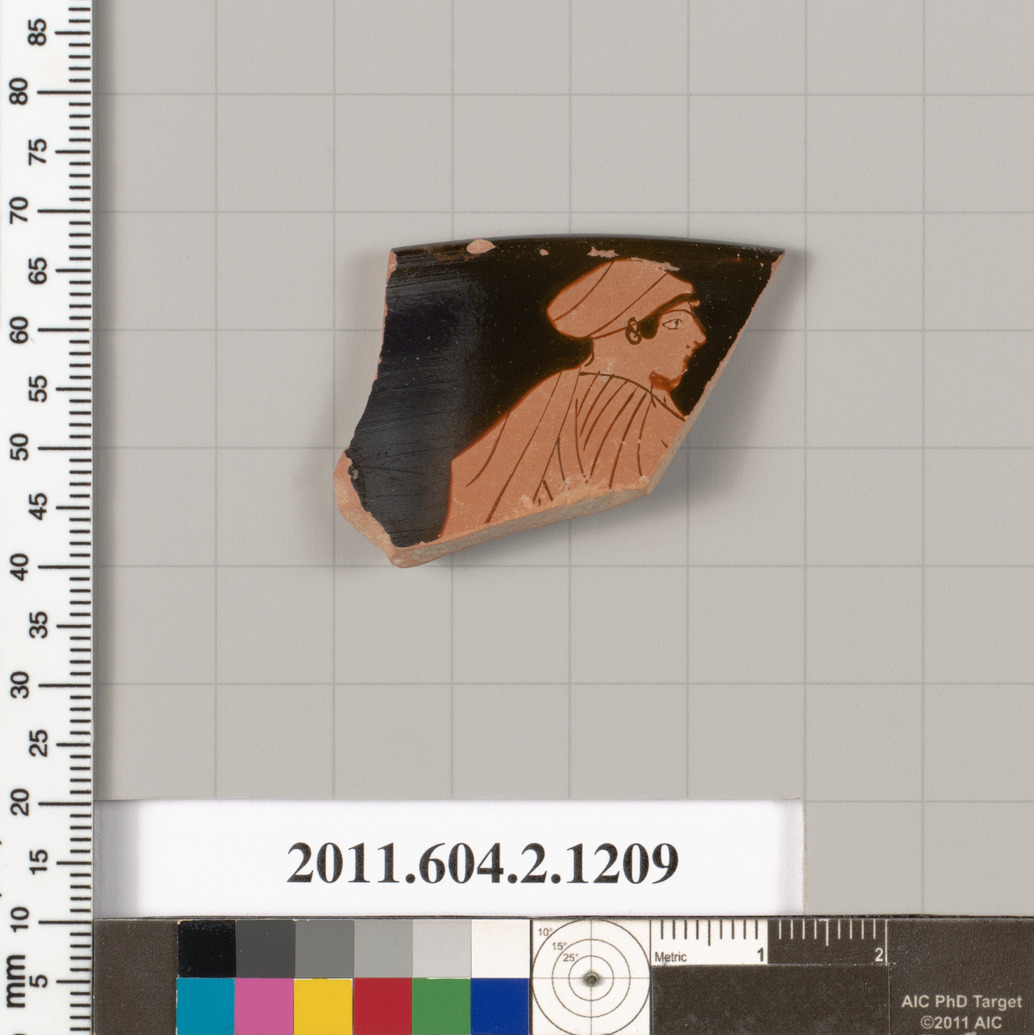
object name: kantharos fragment, head vase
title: Terracotta fragment from a kantharos: head vase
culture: greek, attic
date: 475-451 BCE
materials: terracotta